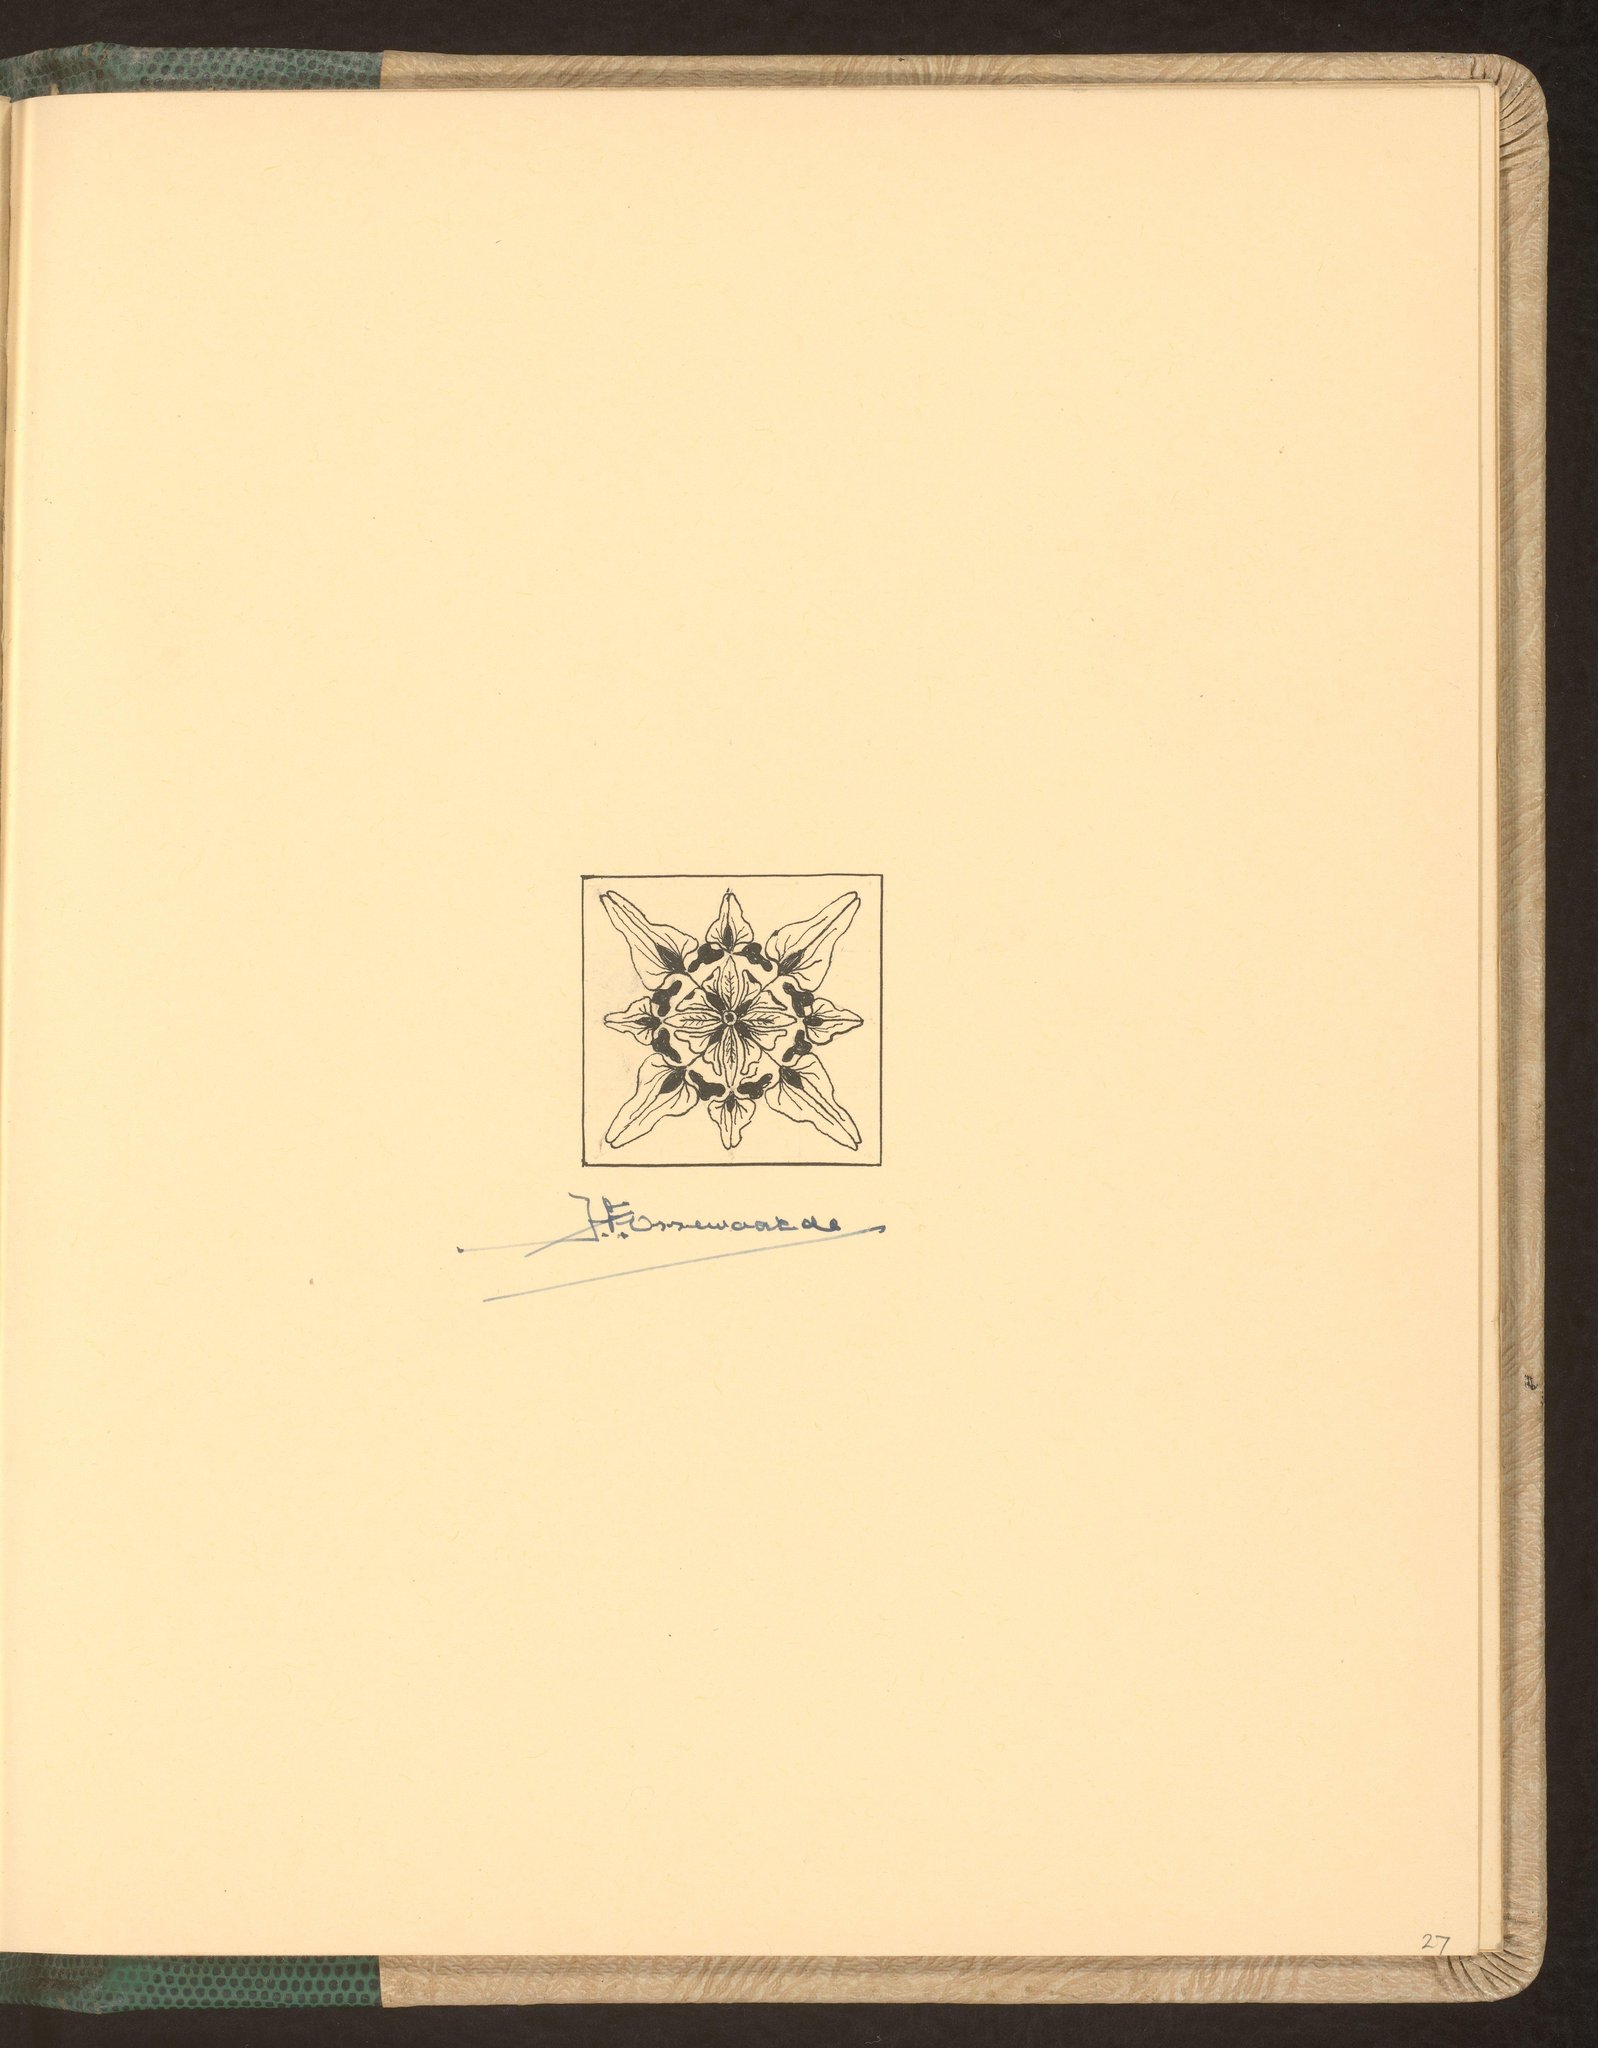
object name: album leaf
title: JHF Ossewaarde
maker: Anonymous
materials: ink, paper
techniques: handwriting, pen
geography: lochem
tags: the hague, willem drees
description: Vierkant embleem met een bloem waaronder de naam van JHF Ossenwwarde. Onderdeel van het fotoalbum over de opening van het bejaardenhuis De Berkelhof in Lochem door premier Willem Drees op 8 augustus 1953.